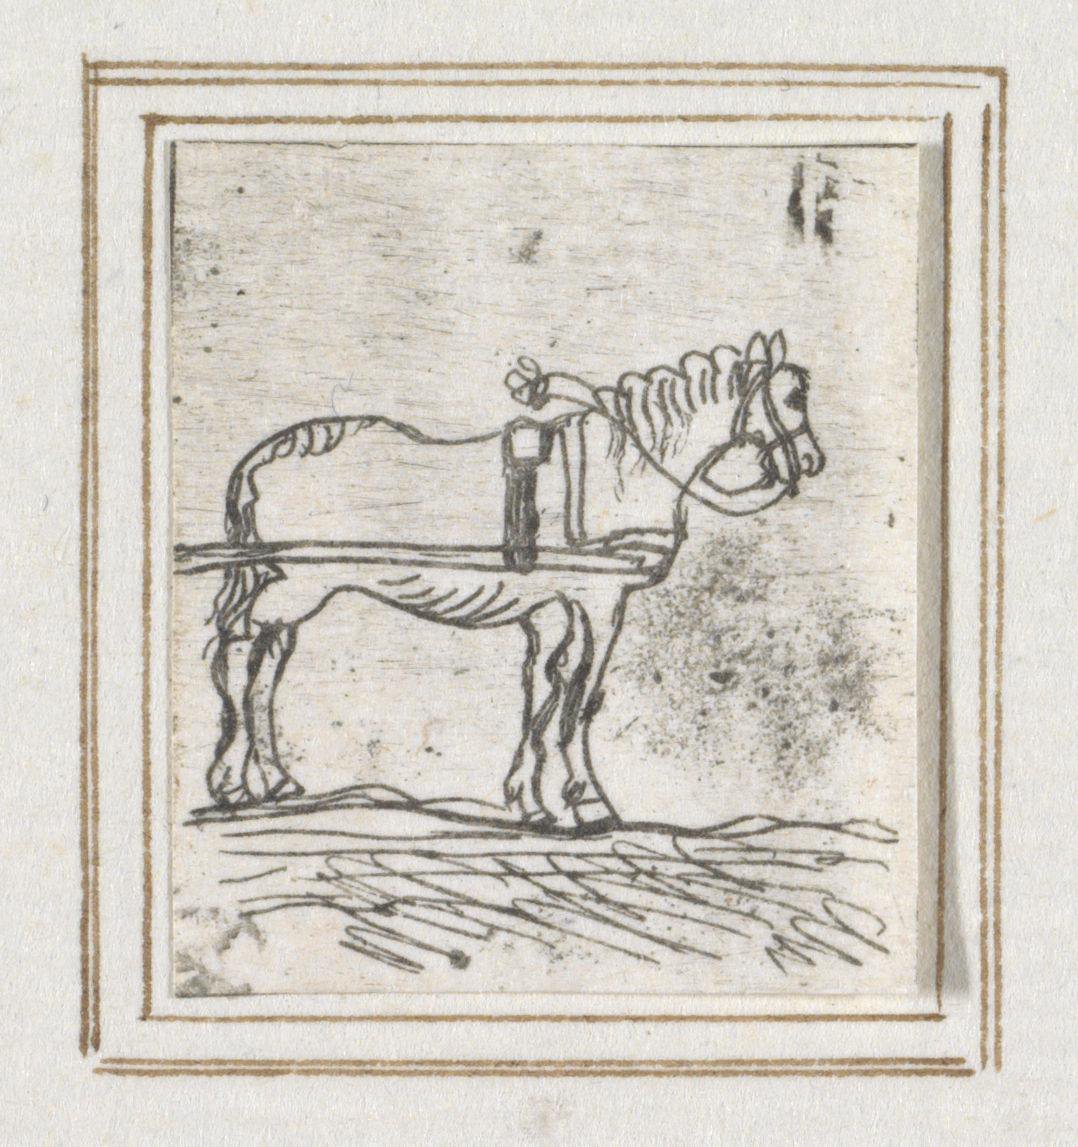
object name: print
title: Ingespannen paard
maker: Anonymous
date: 1700-1900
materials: paper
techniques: etching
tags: horse